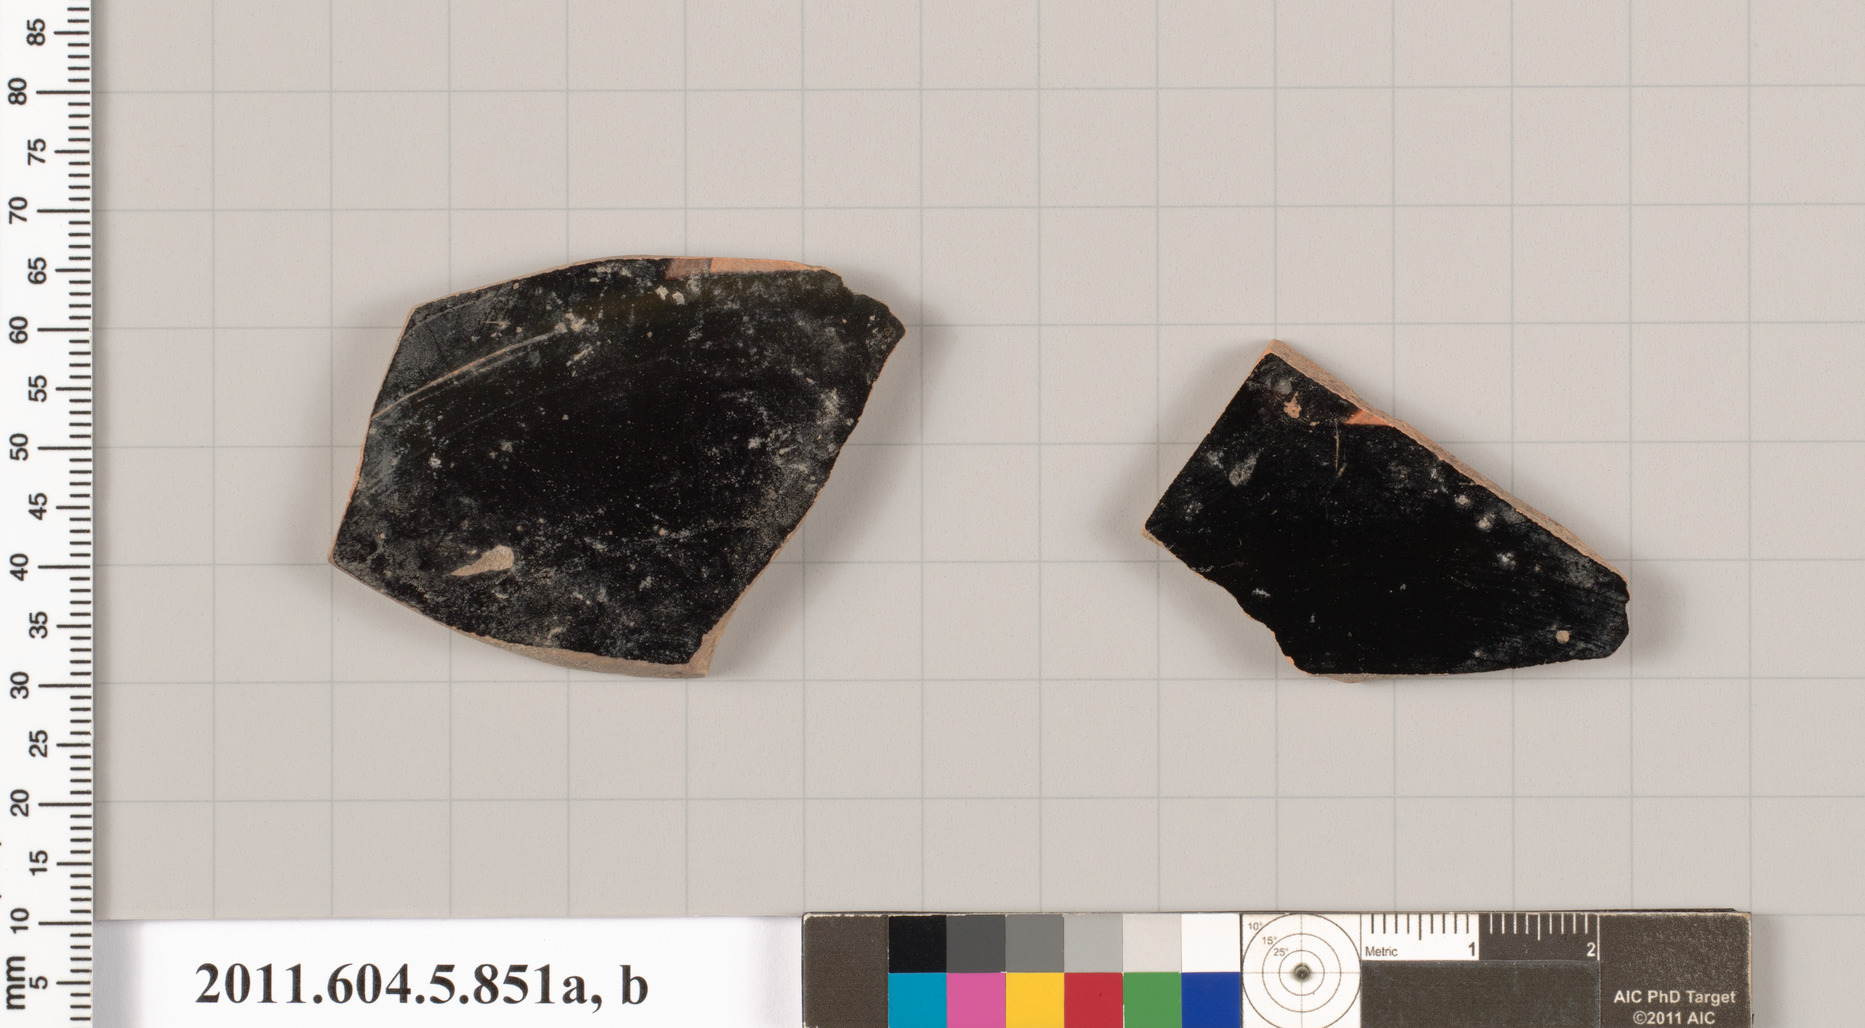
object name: kylix fragment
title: Terracotta fragments of kylikes (drinking cups)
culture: greek, attic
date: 600-401 BCE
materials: terracotta